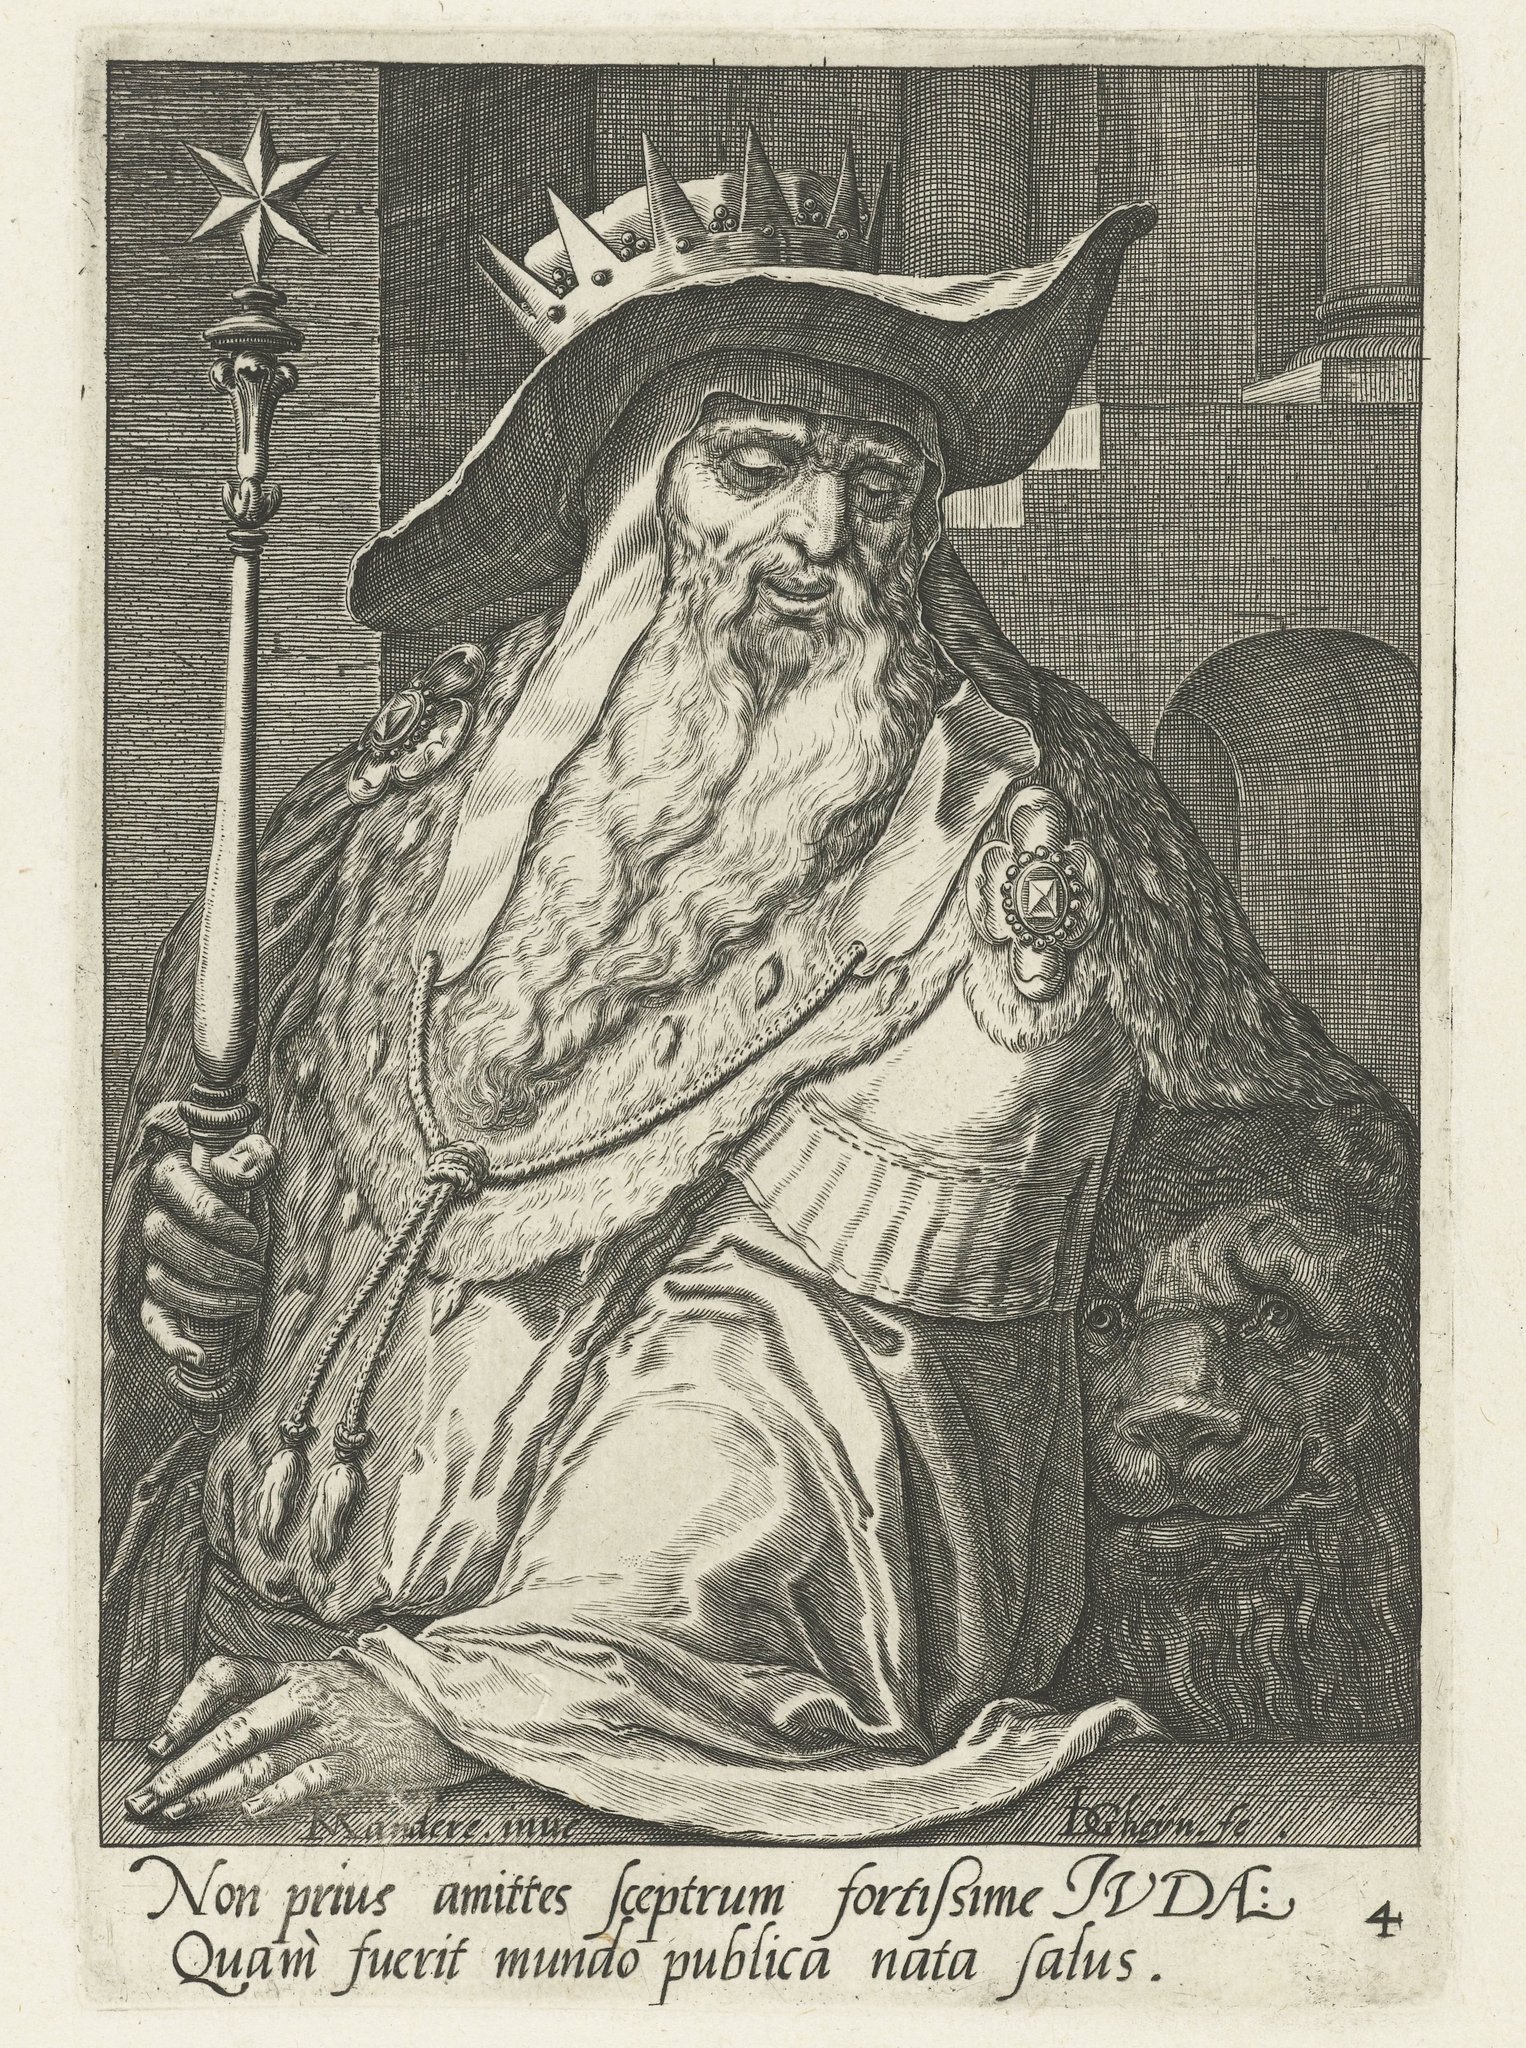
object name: print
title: Stamvader Juda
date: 1587-1591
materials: paper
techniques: engraving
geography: netherlands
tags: the twelve patriarchs together, i.e. the twelve (grand)sons of jacob, eponymous ancestors of the twelve tribes of israel, male persons from the old testament (with name) (not in biblical context), the lion of judah, the twelve tribes of israel (with name) (not in biblical context)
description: Stamvader Juda, ten halven lijve, in architectonische omgeving, in de rechterhand een staf. Aan zijn linkerzijde de kop van een leeuw (een verwijzing naar Juda's bijnaam 'leeuwenwelp', of naar Christus 'de leeuw van Juda'). Onder de voorstelling twee regels tekst in Latijn. Deze prent is onderdeel van een serie van twaalf stamvaders van |sraël; elke prent in deze serie bestaat uit een beeltenis van een stamvader, ten halven lijve, en een tweeregelig onderschrift in Latijn.